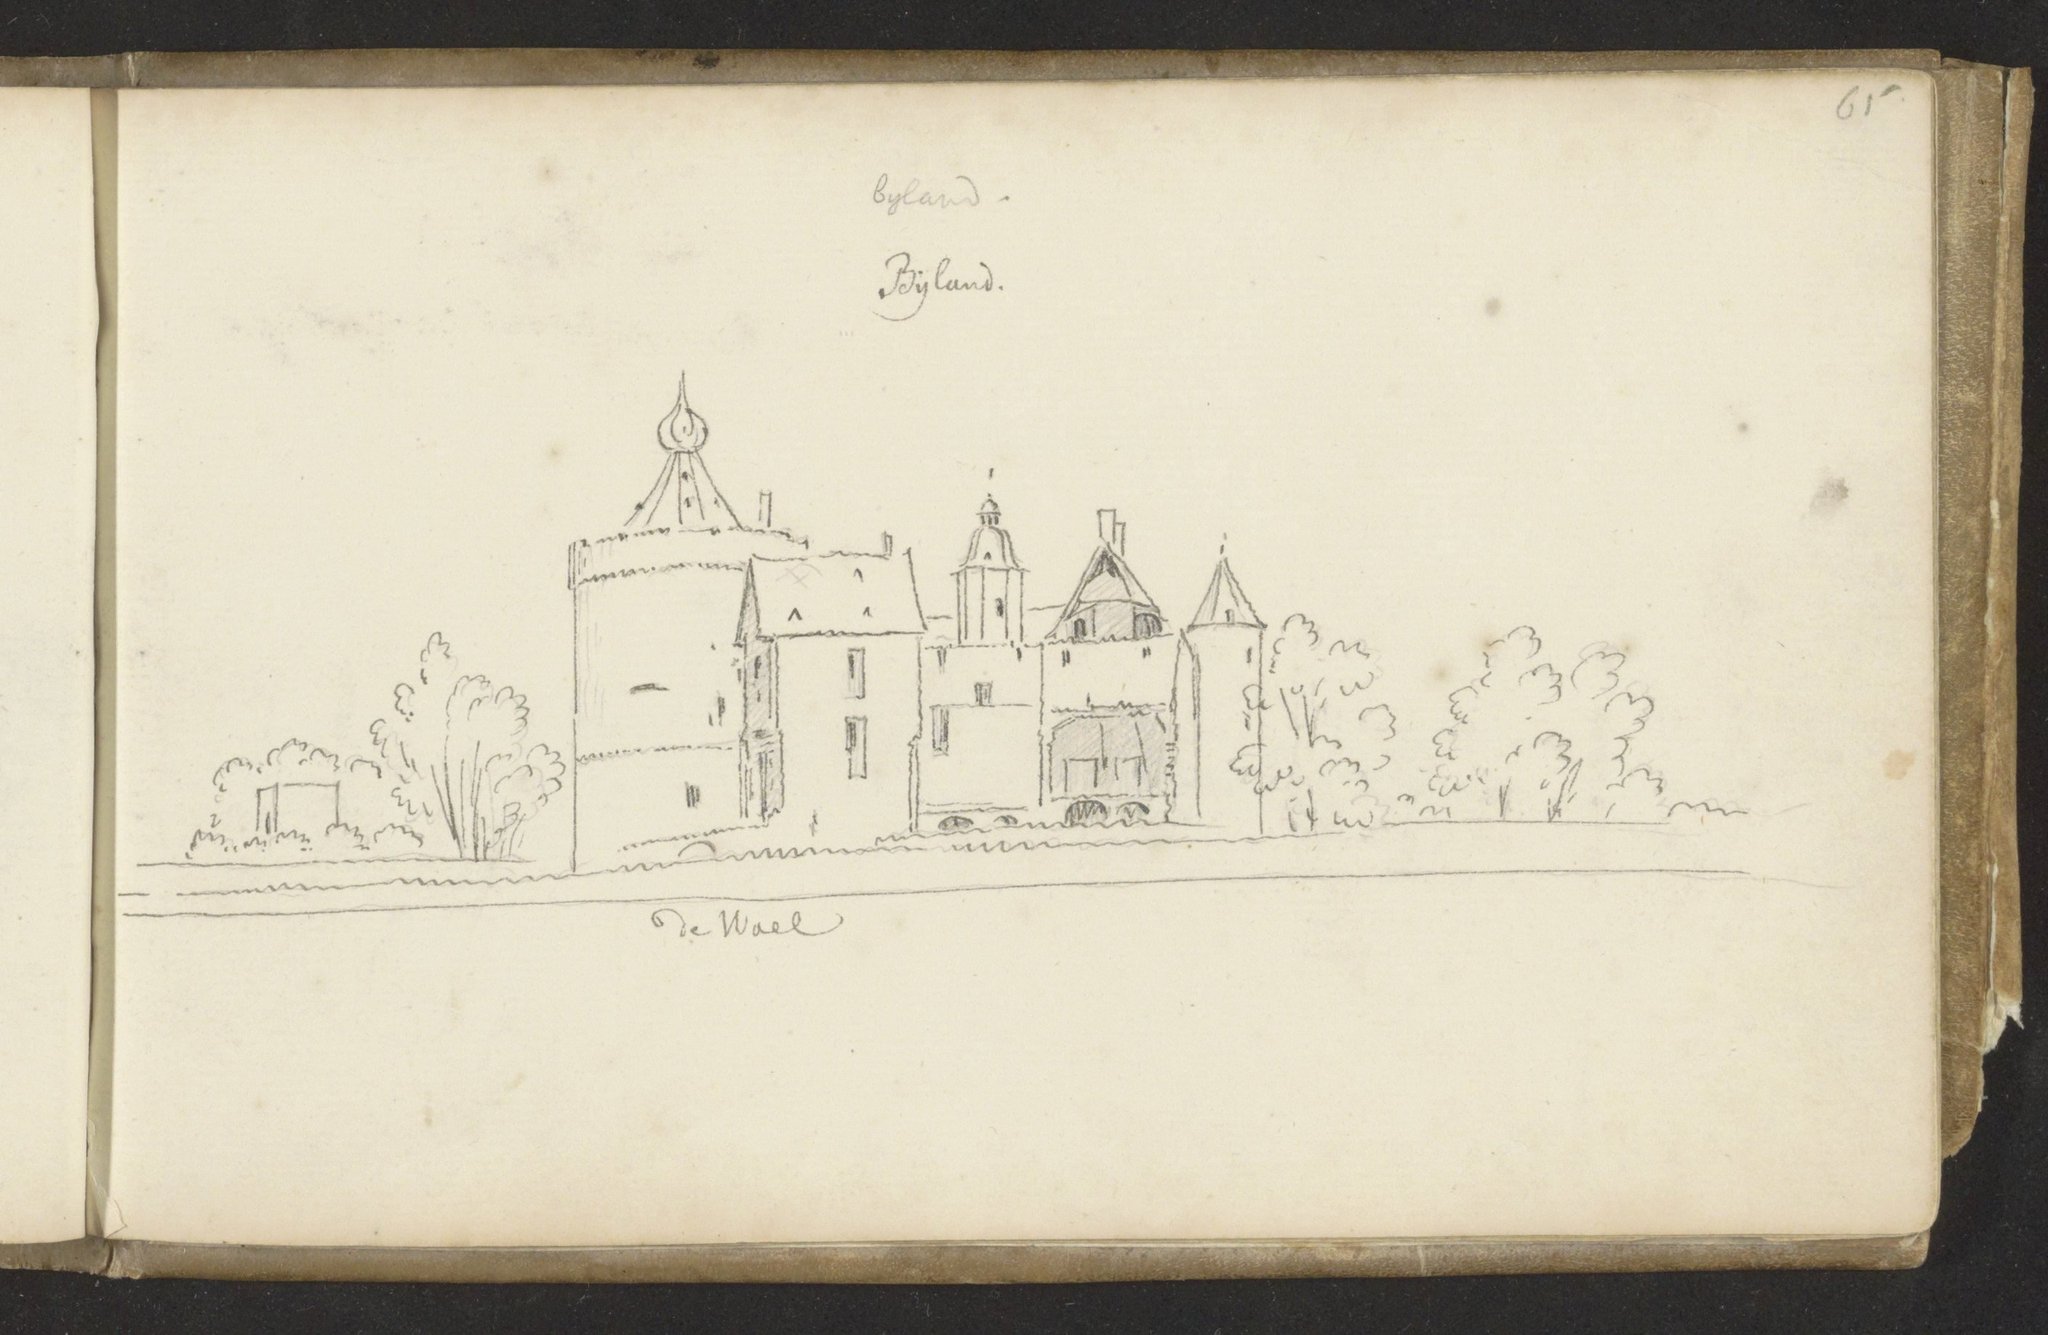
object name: sketchbook leaf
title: Kasteel Bijland te Herwen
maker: abraham de haen (ii)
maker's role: draughtsman, print maker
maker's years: 1707-1748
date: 1731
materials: ink, paper, pencil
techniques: pen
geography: herwen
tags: castle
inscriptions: annotation: ‘bijland/ de Wael’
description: Blad 65 recto uit een schetsboek met 69 bladen.